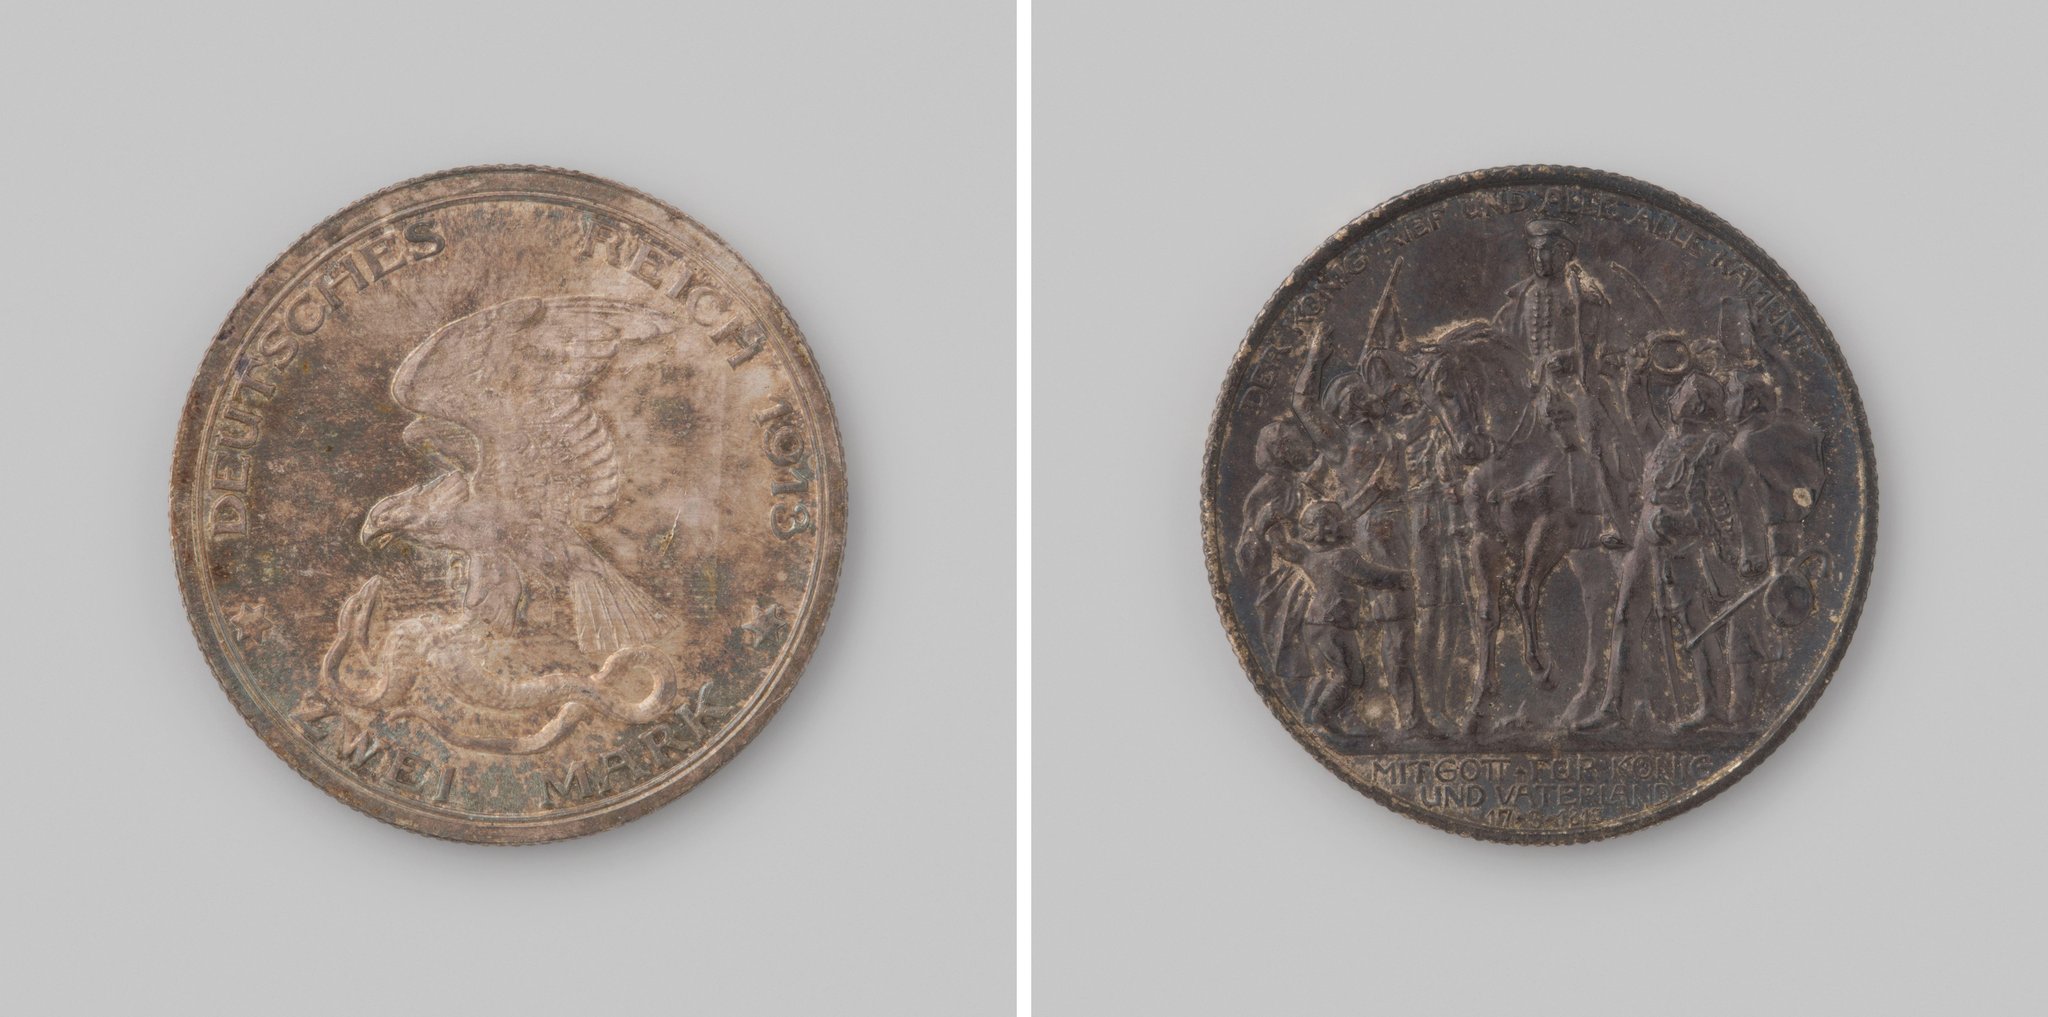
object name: twee mark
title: Duitse Rijk, Pruisen, Wilhelm II, 2 Mark, 1913 A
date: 1913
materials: silver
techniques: striking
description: Zilveren herdenkingsmunt. Voorzijde: adelaar die slang doodt. Waarde-aanduiding en jaartal in omschrift. Keerzijde: koning te paard die door juichende menigte wordt omringd. In afsnede datum 17-3-1813. Kartelrand.